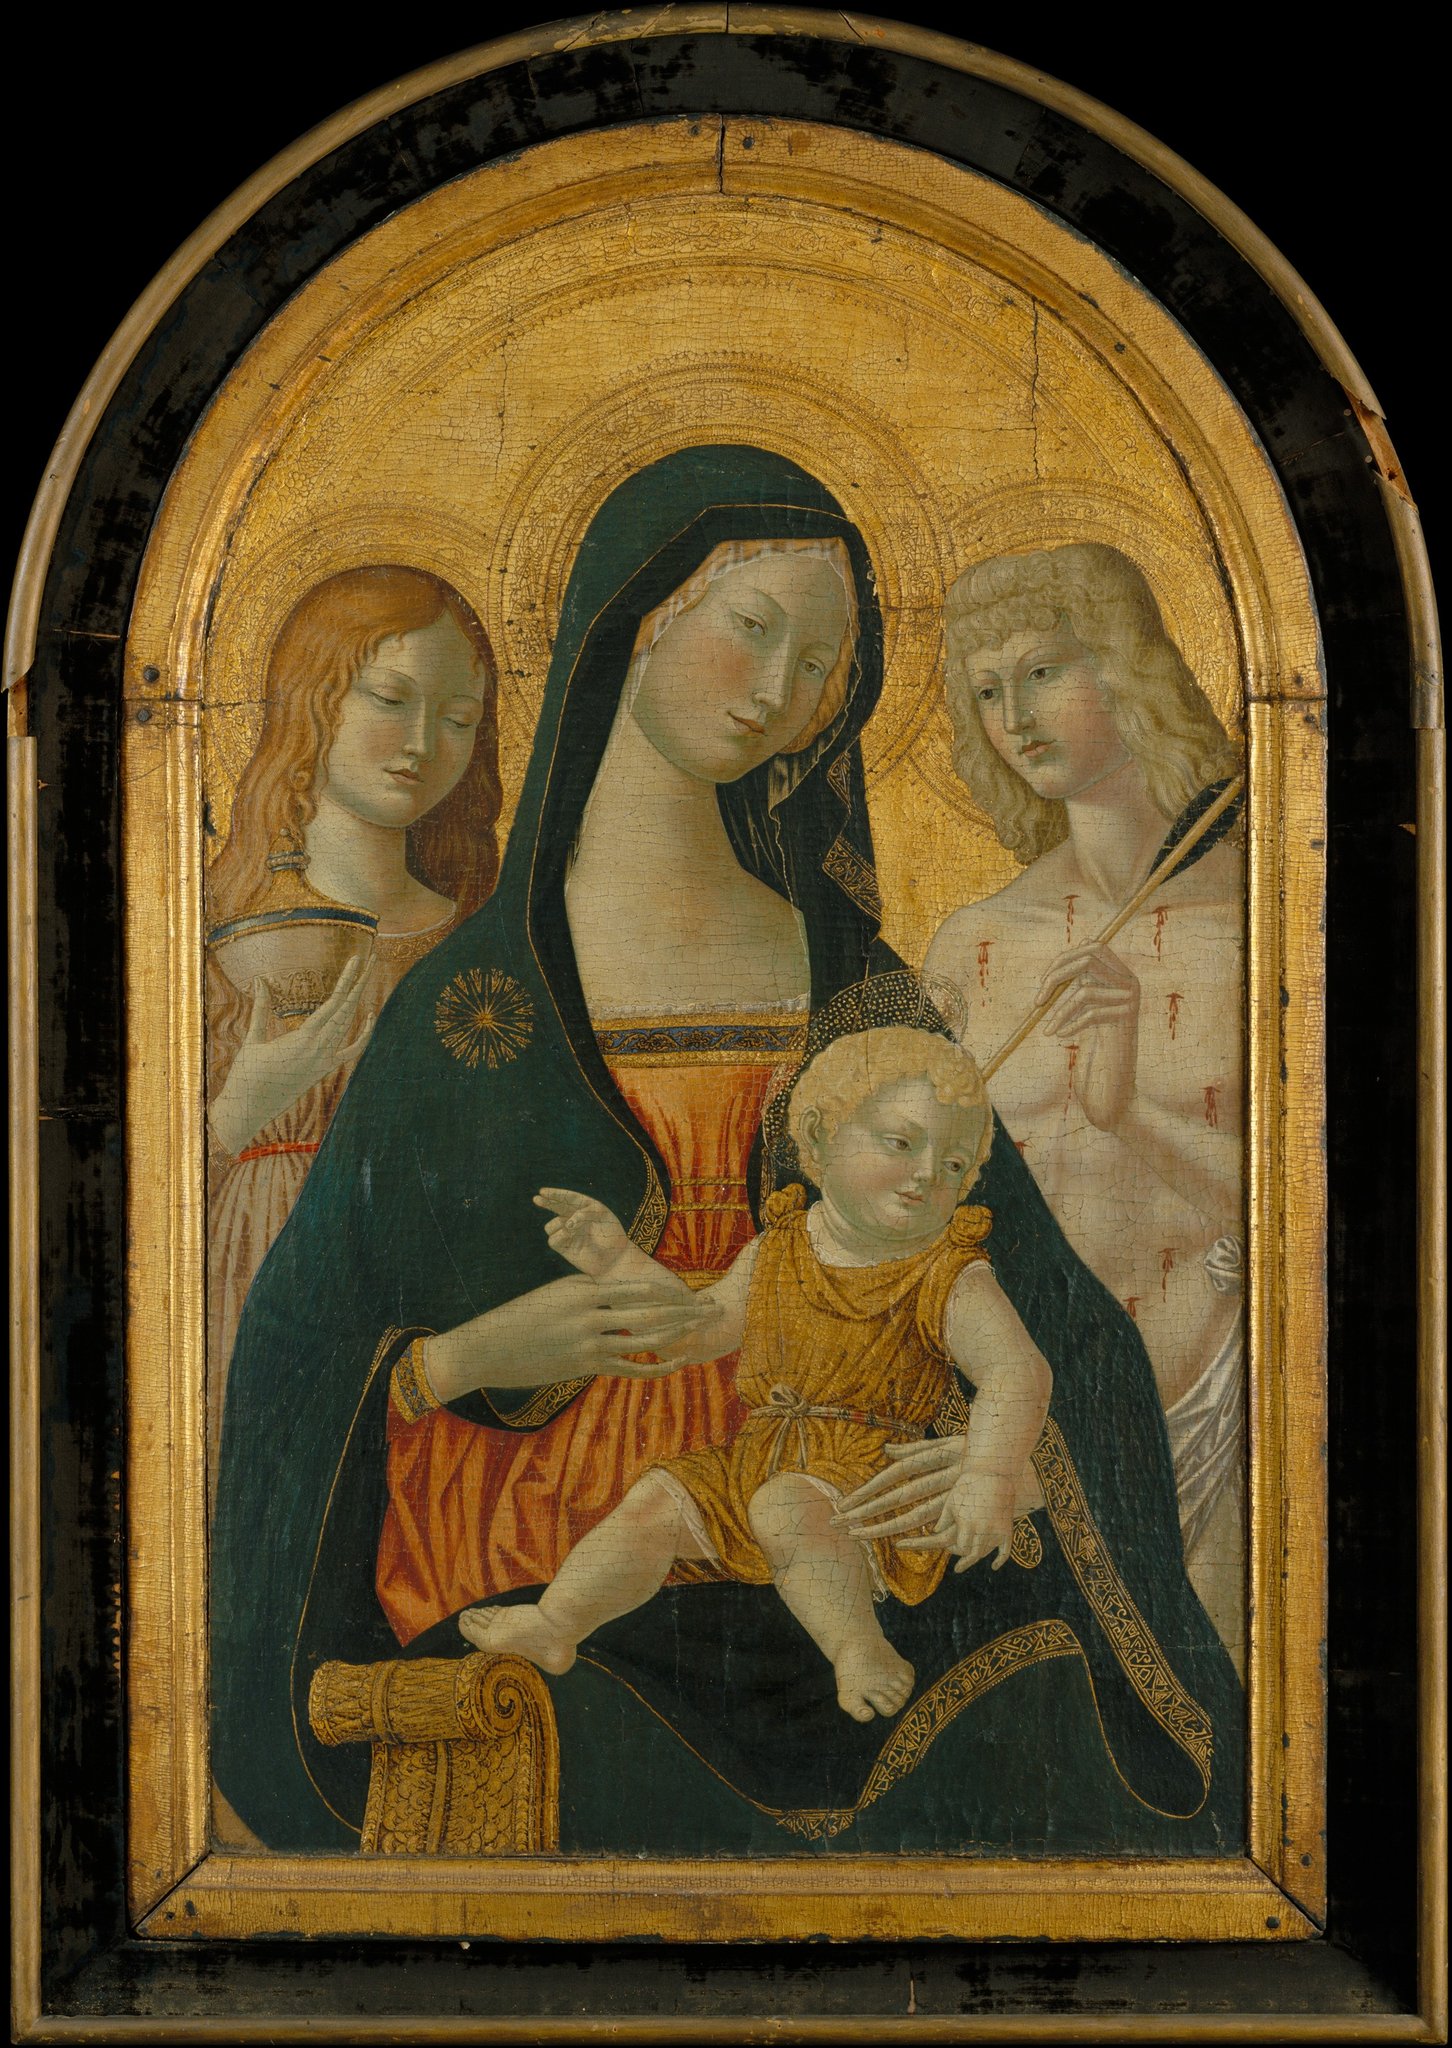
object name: painting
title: Madonna and Child with Saints Mary Magdalen and Sebastian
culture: italian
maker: icilio federico ioni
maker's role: artist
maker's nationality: italian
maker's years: 1866-1946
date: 1401-1500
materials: gold leaf, paint, wood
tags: madonna and child,mary magdalene,saints